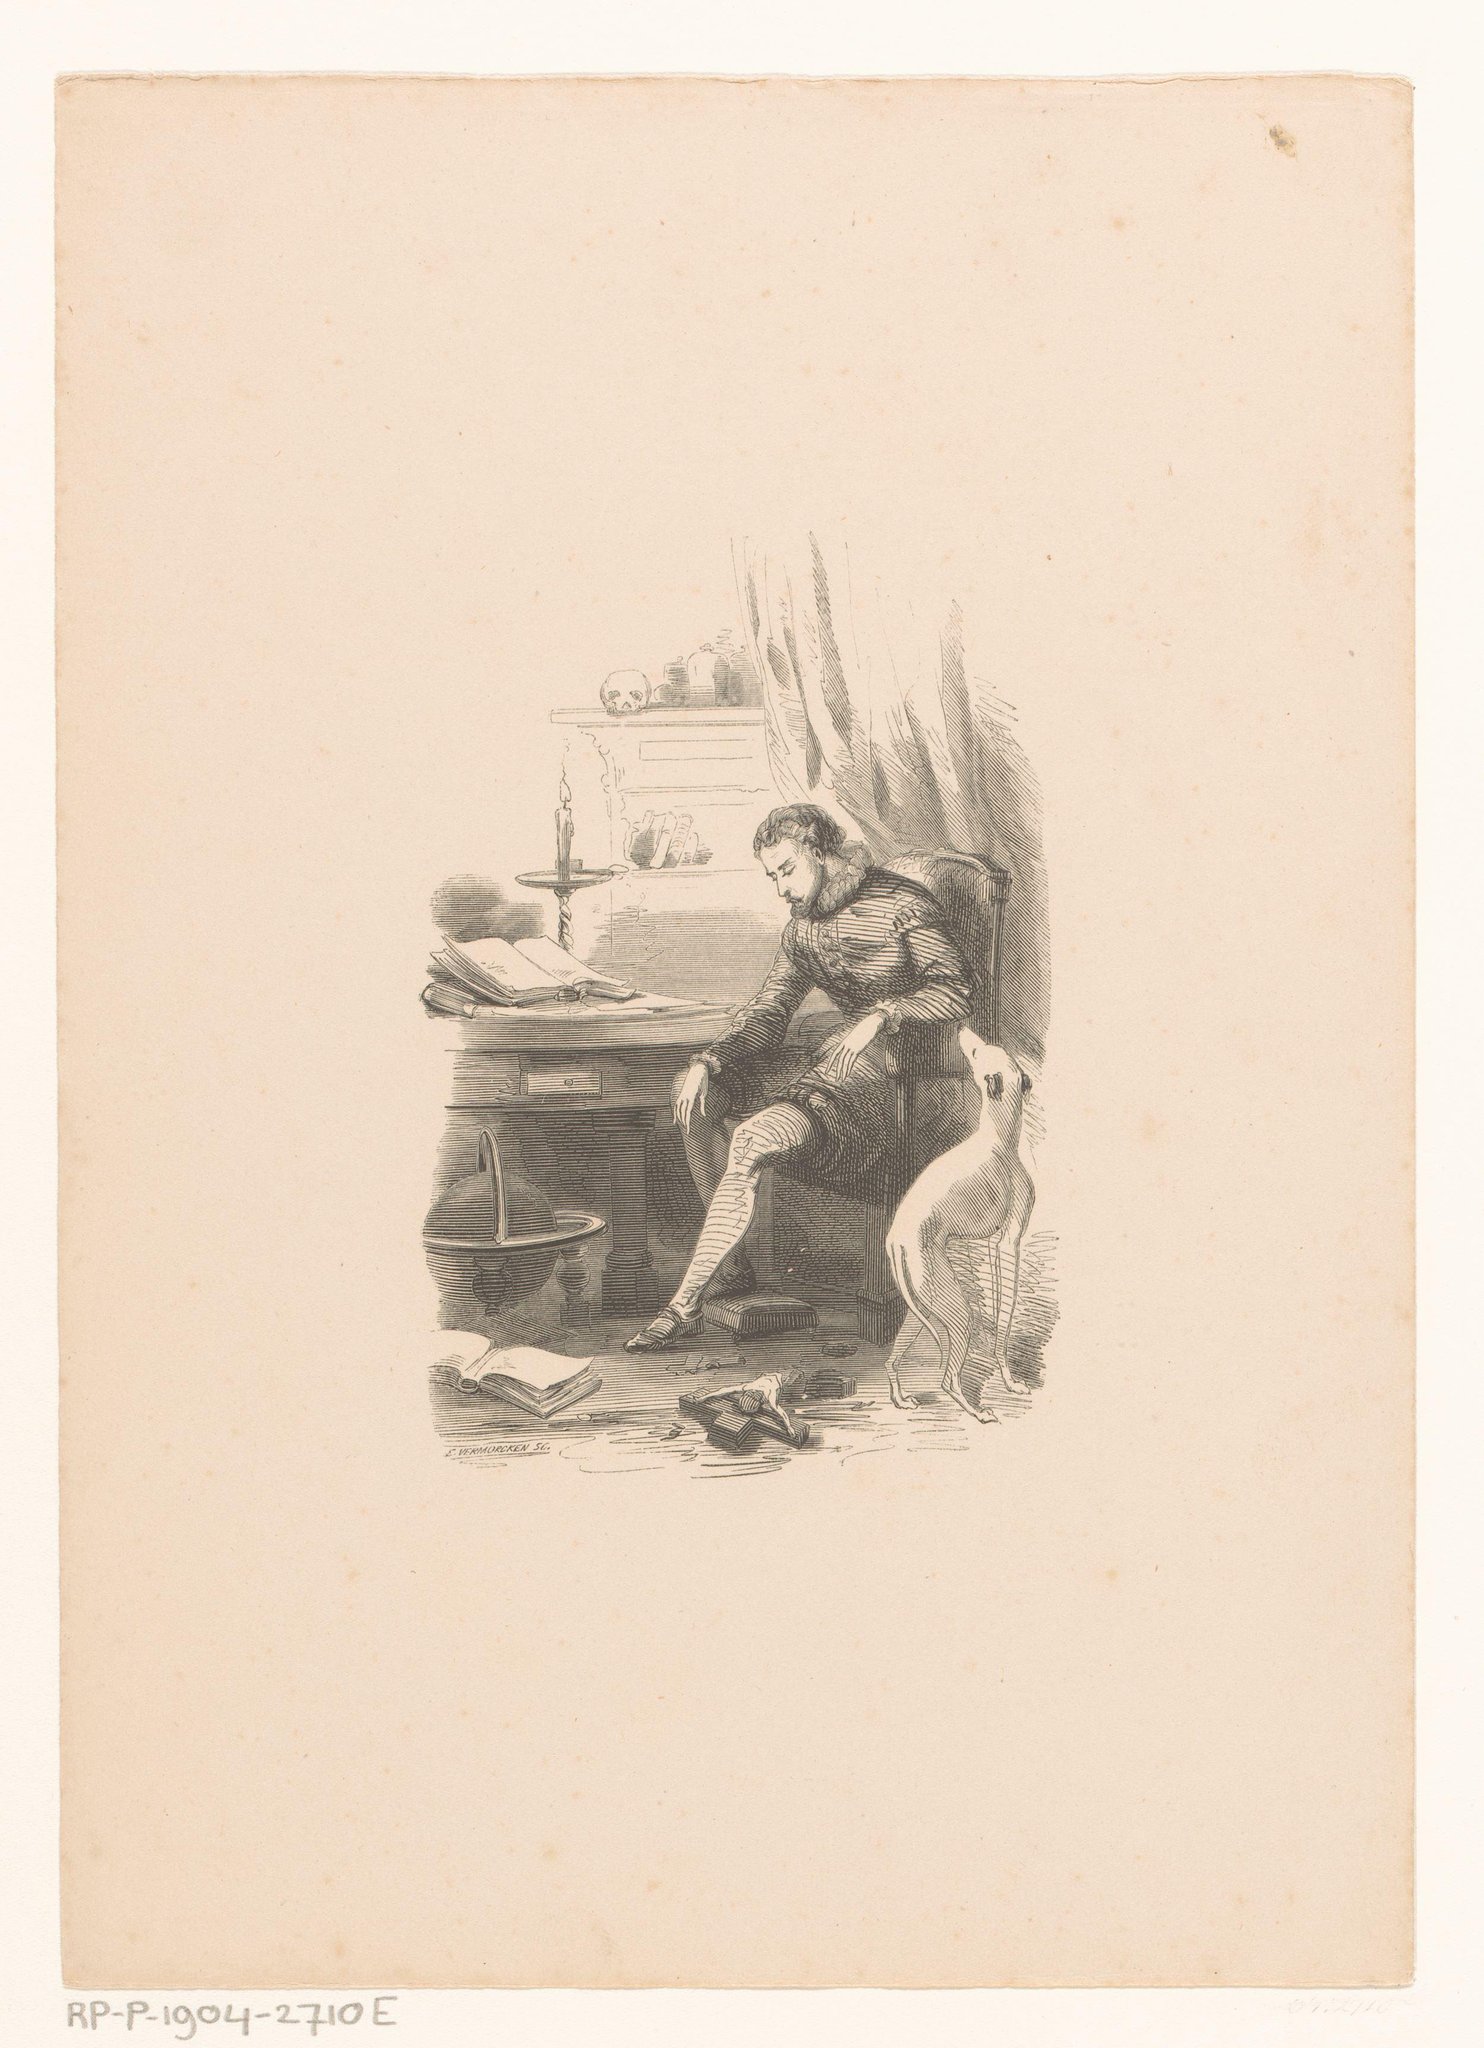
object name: print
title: Historische taferelen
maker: edouard vermorcken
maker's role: print maker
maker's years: 1820-1906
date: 1830-1904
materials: paper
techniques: engraving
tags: dog (with name of kind), nobility and patriciate; chivalry, knighthood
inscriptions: collector's mark: Lugt 2228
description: Prent maakt deel uit van een serie van een onbekend aantal prenten, waarvan het Rijksmuseum Amsterdam er in elk geval zes bezit: RP-P-1904-2710A t/m F.